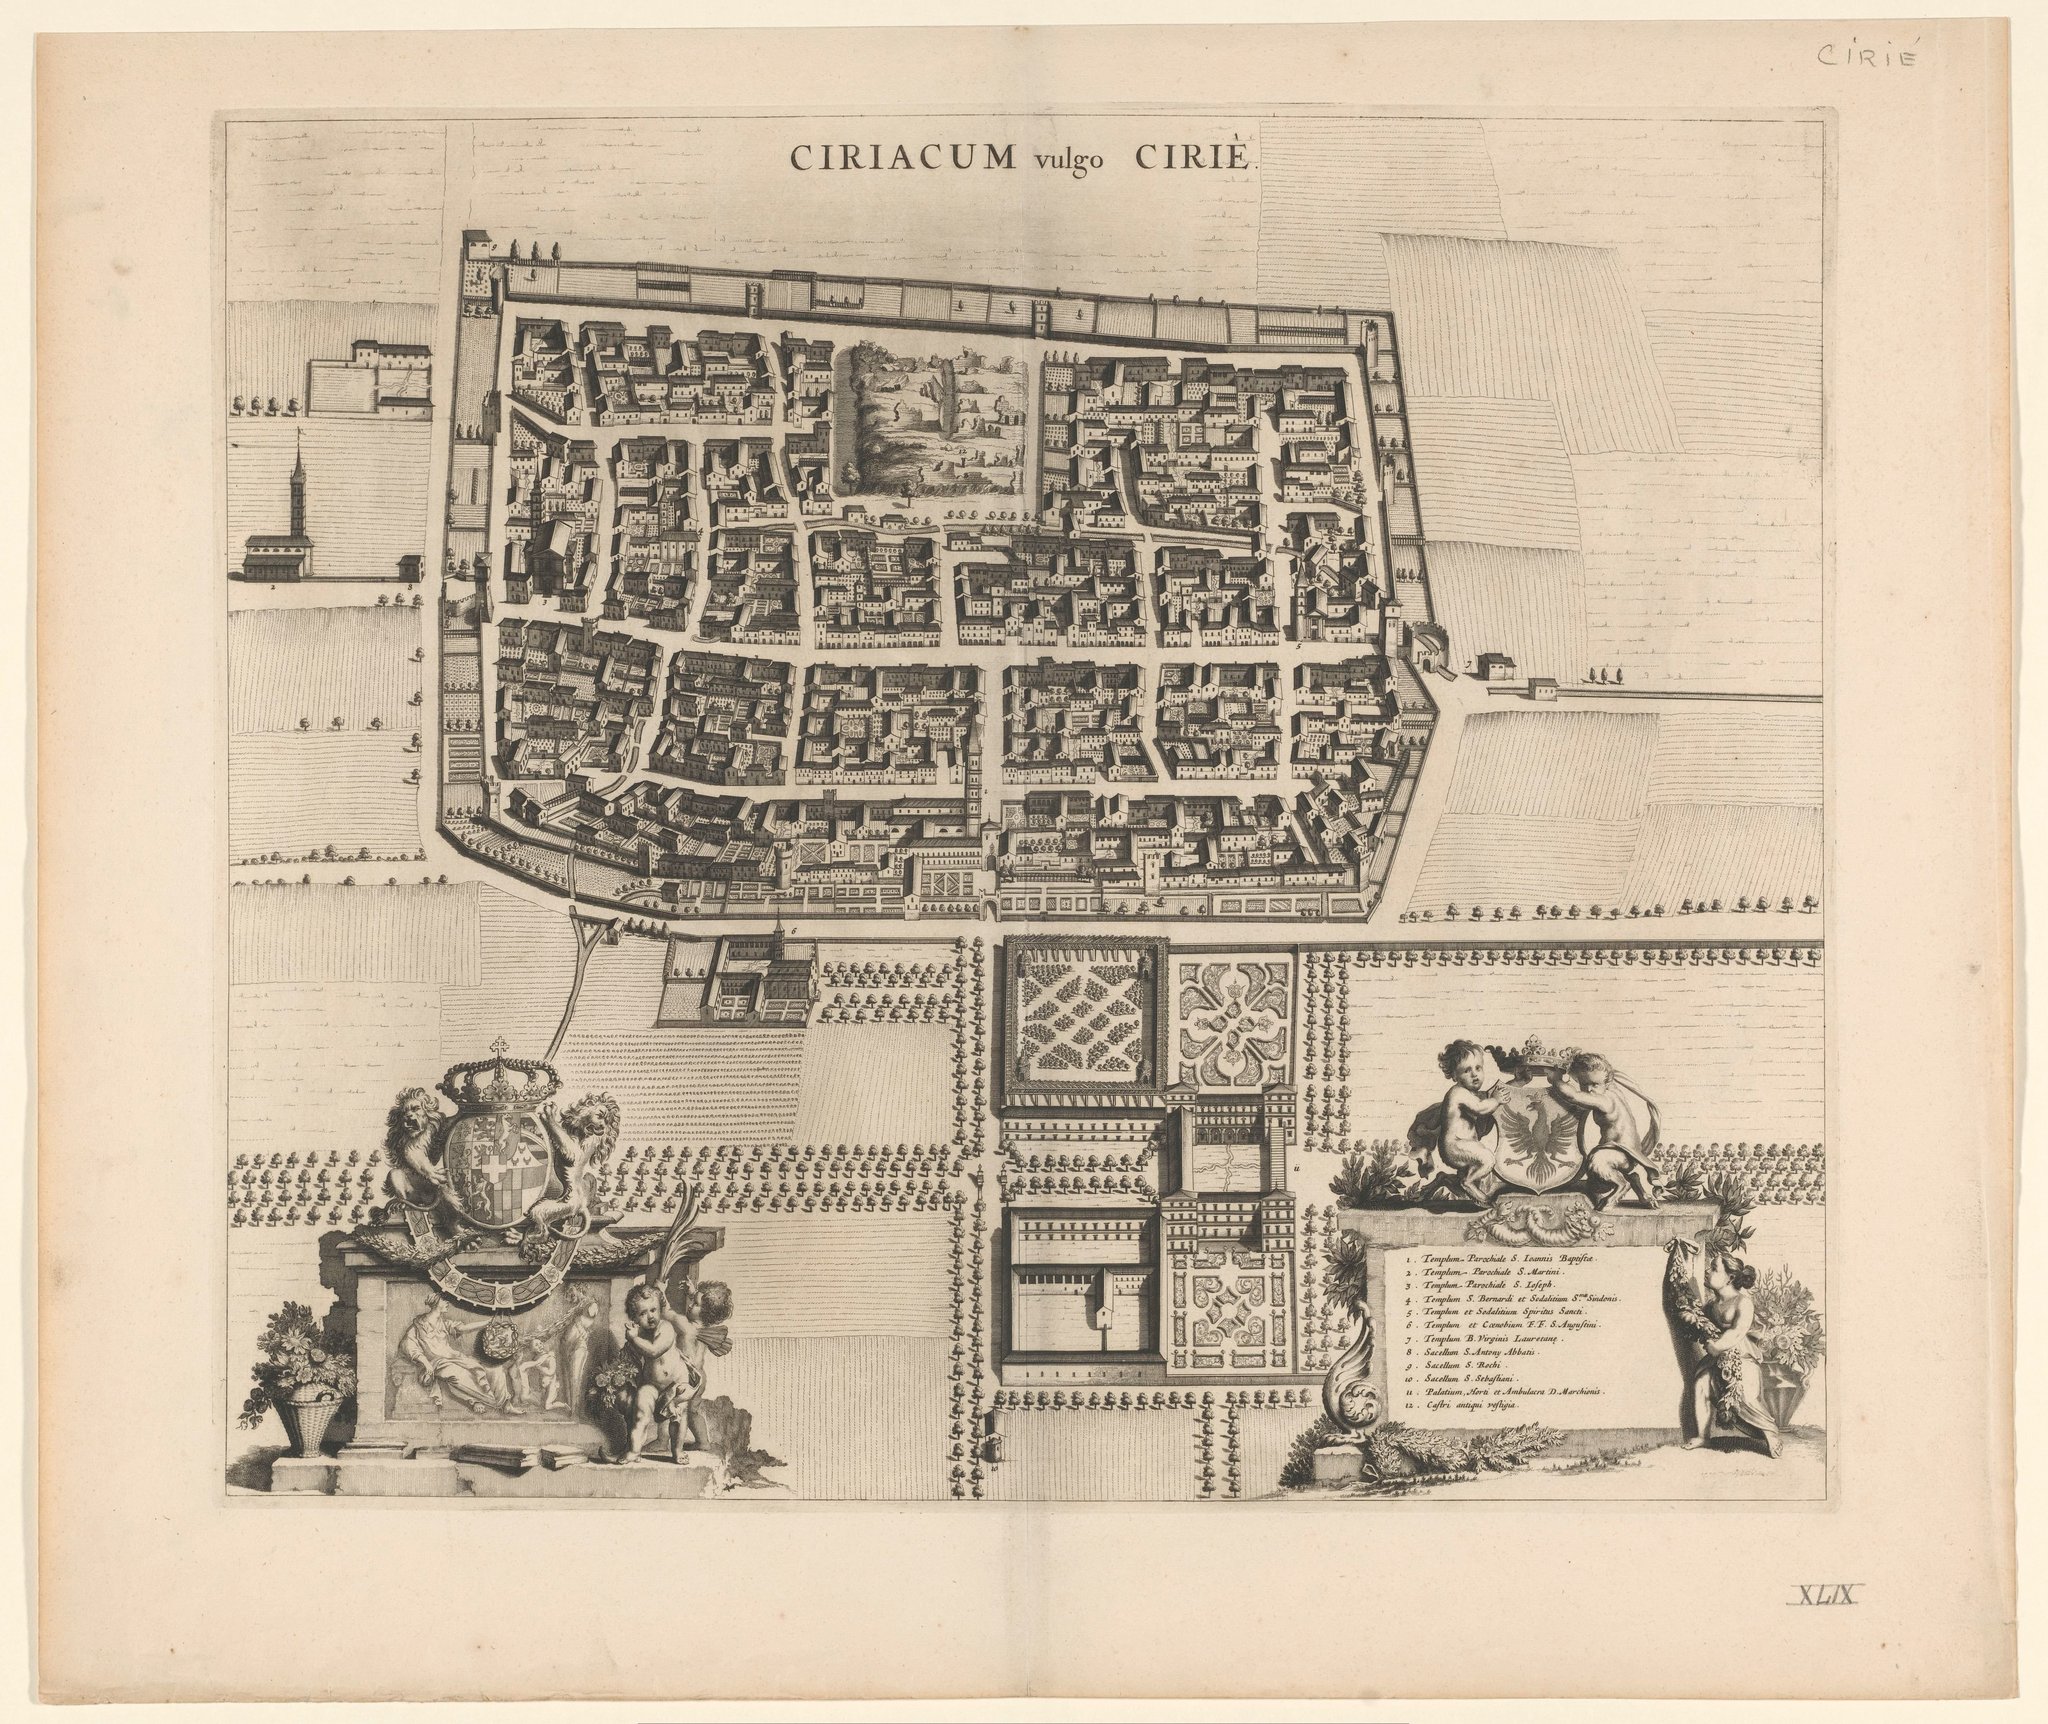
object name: print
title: Ciriacum vulgo Ciriè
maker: Anonymous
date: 1682-1697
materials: paper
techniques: engraving, etching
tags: maps of cities, armorial bearing, heraldry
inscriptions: collector's mark: Lugt 2228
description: Plattegrond van Ciriè met gebouwen in vogelvluchtperspectief. Linksonder het wapen van de hertog van Savoye, rechtsonder het wapen van de familie Doria.